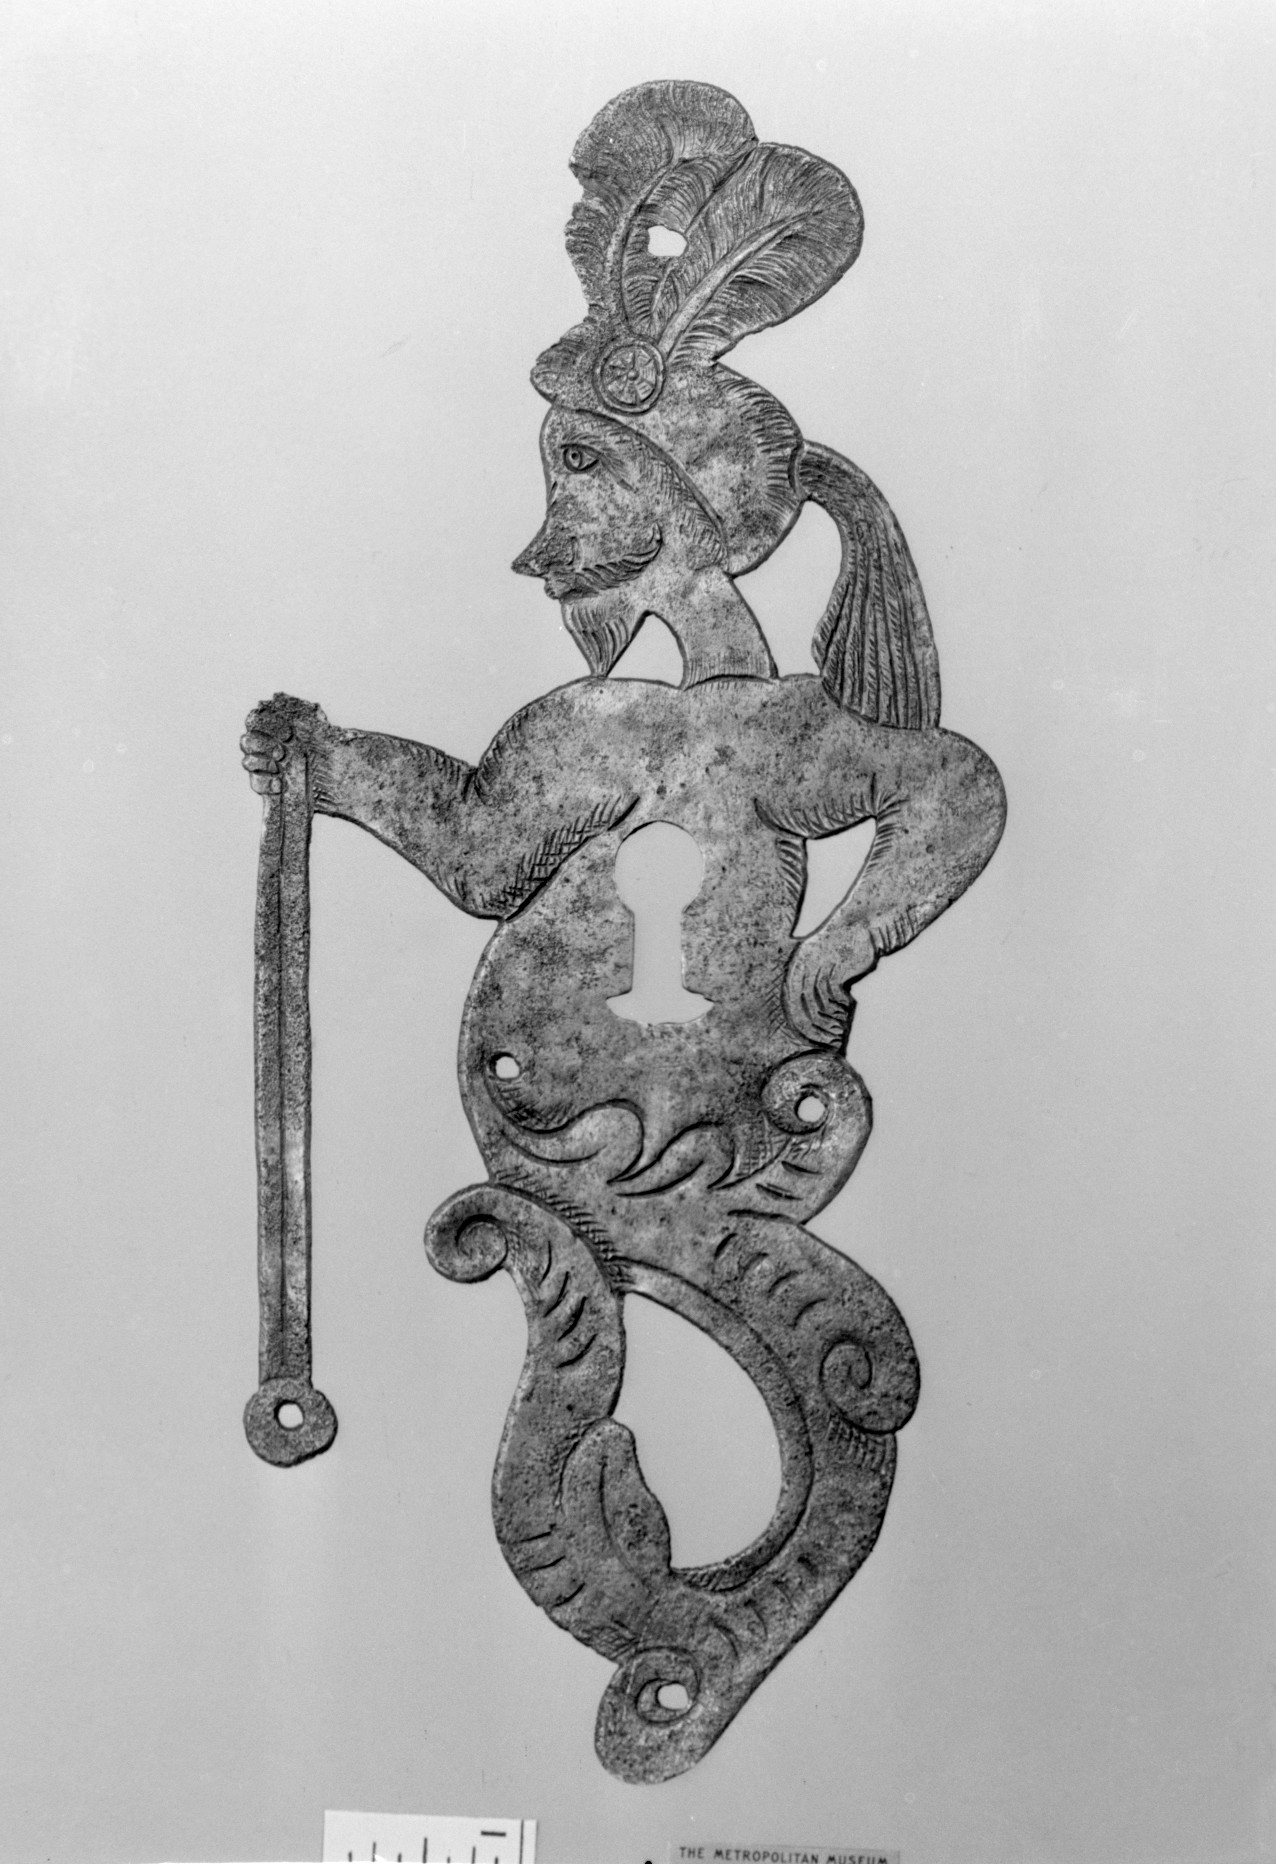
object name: keyhole escutcheon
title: Pair of keyhole escutcheons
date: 1567-1600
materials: iron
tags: men